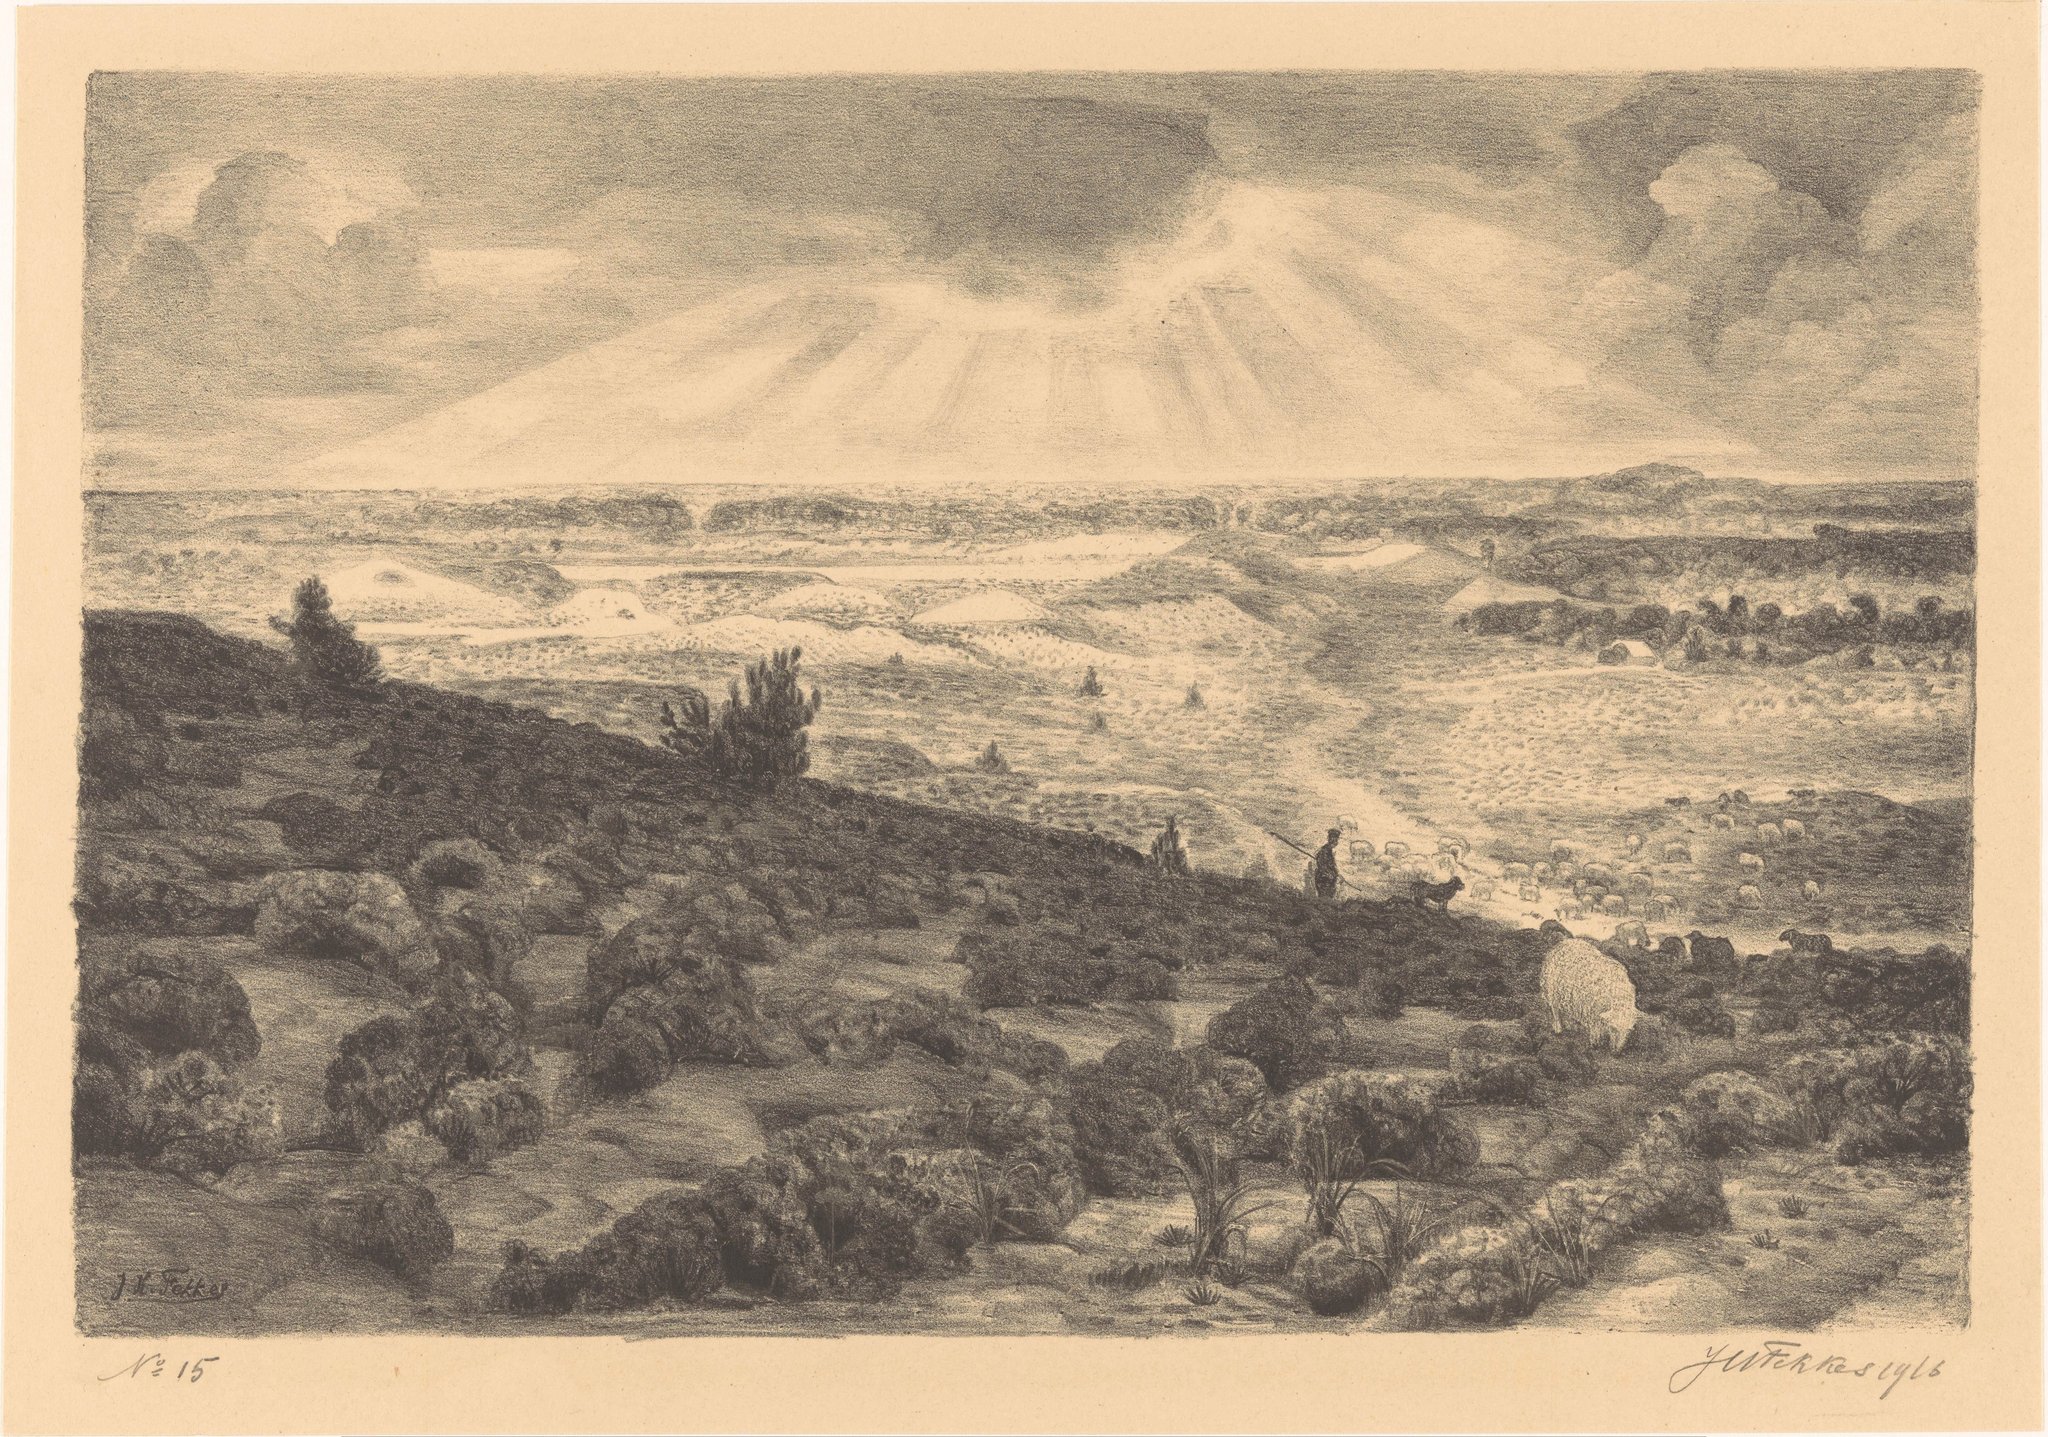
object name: print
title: Heide bij Laren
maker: jan fekkes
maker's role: draughtsman, print maker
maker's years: 1885-1933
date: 1916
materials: paper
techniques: lithograph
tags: herding, herdsman, herdswoman, shepherd, shepherdess, cowherd, etc., sheep, grasslands, savanna, prairie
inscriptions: collector's mark: Lugt 2233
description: Op de heide een herder met herdershond en een kudde schapen.